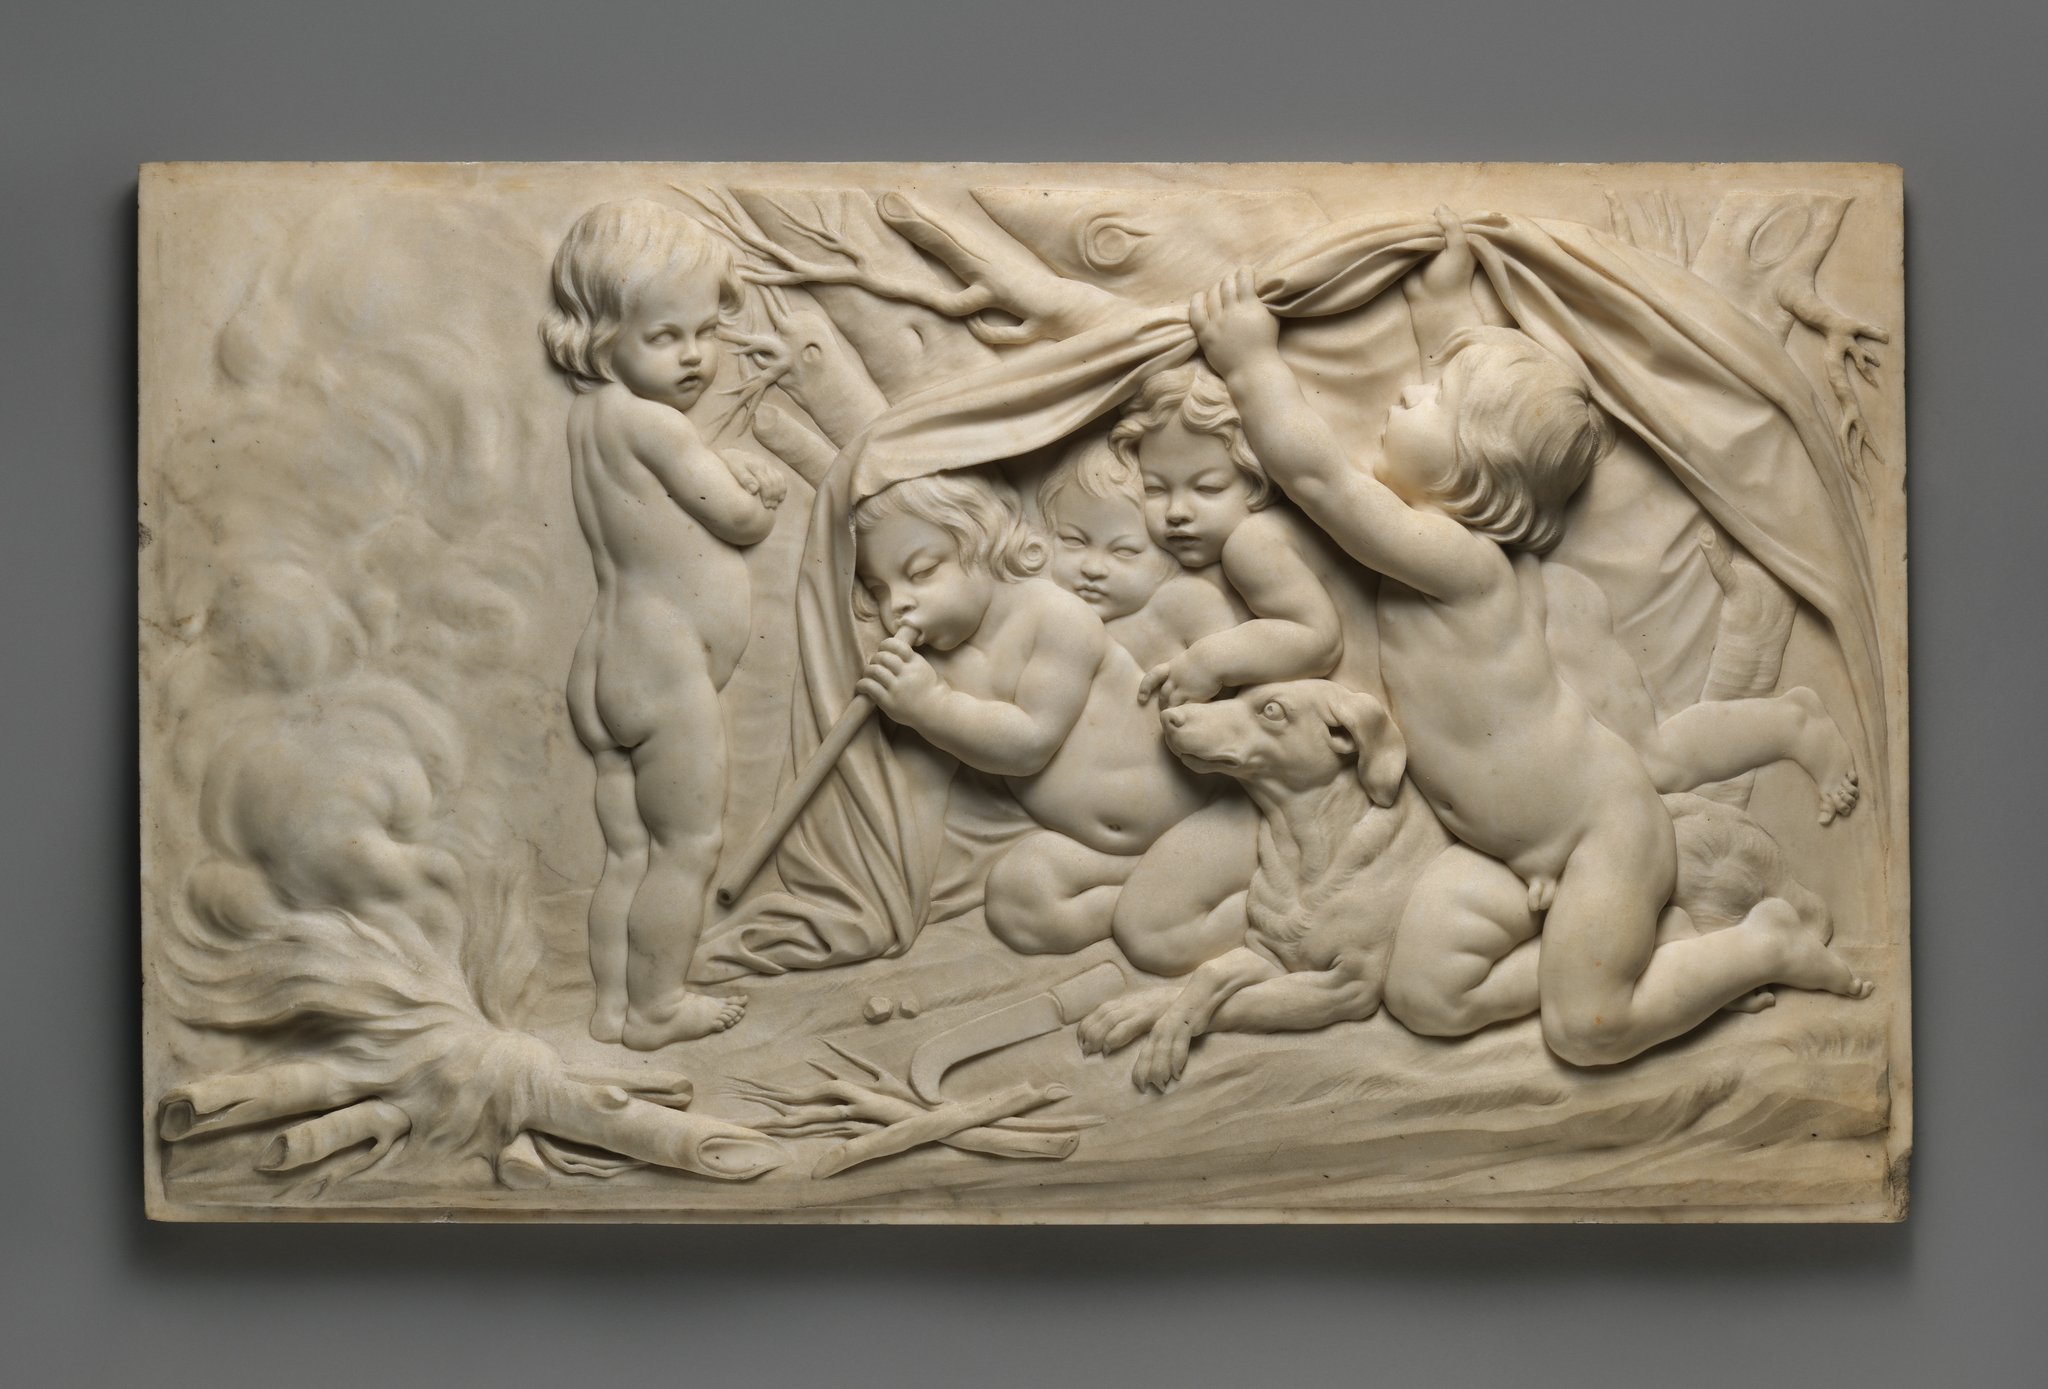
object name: relief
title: Winter (one of a set of four)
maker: edme bouchardon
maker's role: artist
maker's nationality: french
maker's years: 1698-1762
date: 1734-1766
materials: marble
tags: children,dogs,winter